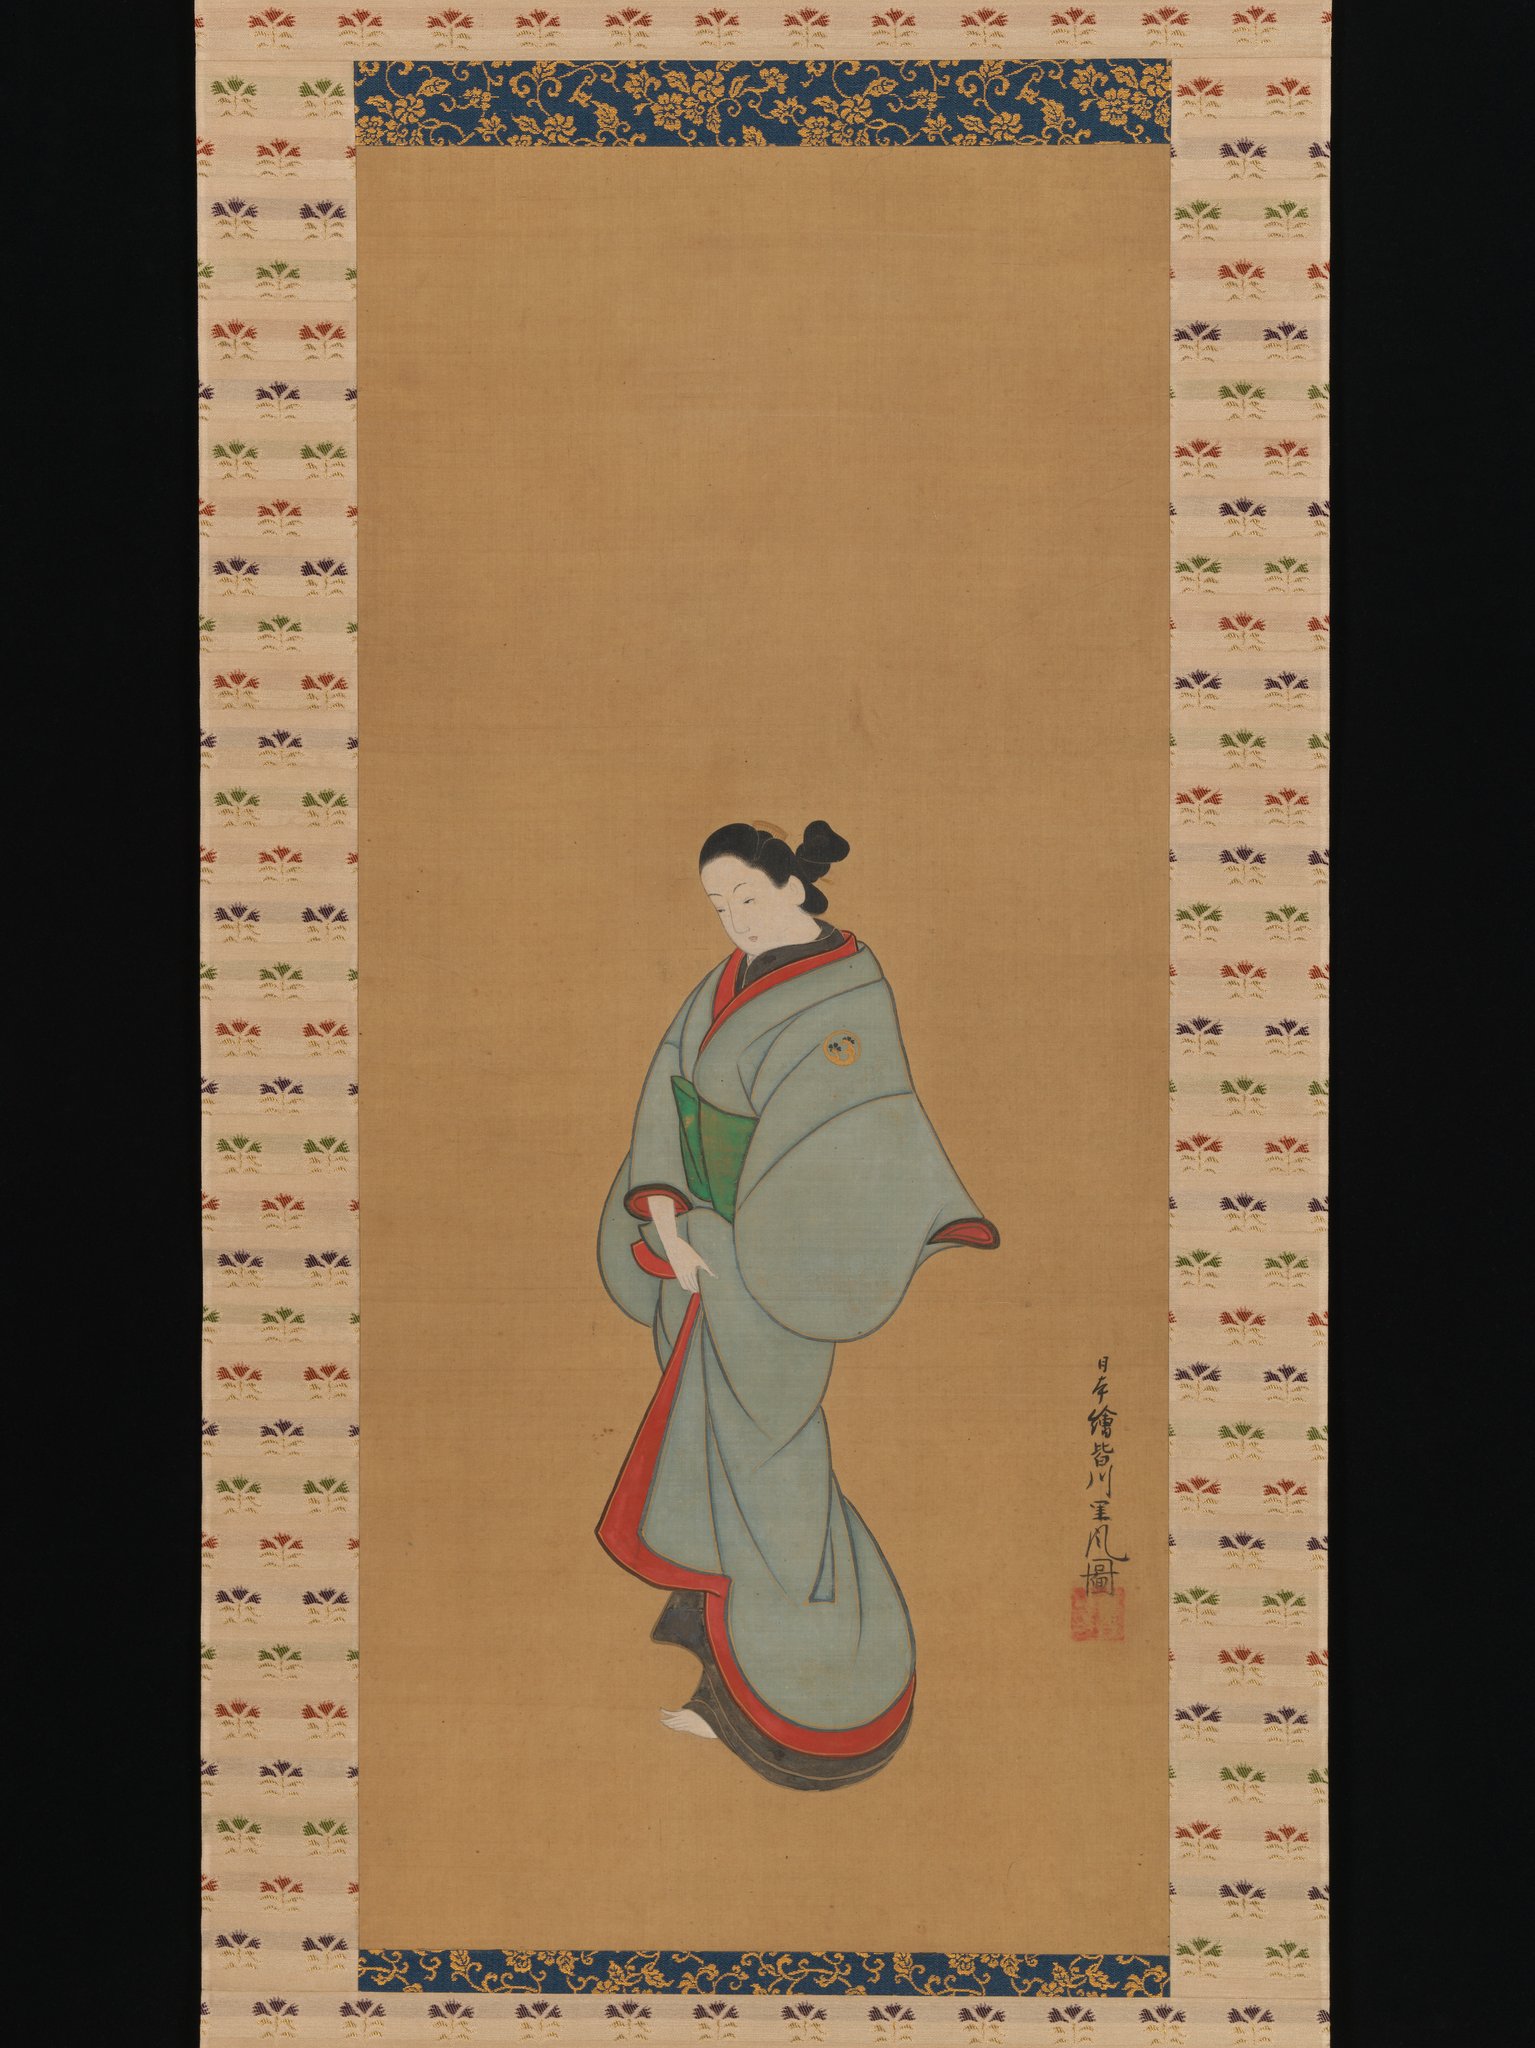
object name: hanging scroll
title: Standing Woman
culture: japanese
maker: tōsendō rifū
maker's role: artist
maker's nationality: japanese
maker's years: 1720-1740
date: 1730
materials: ink, silk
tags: women